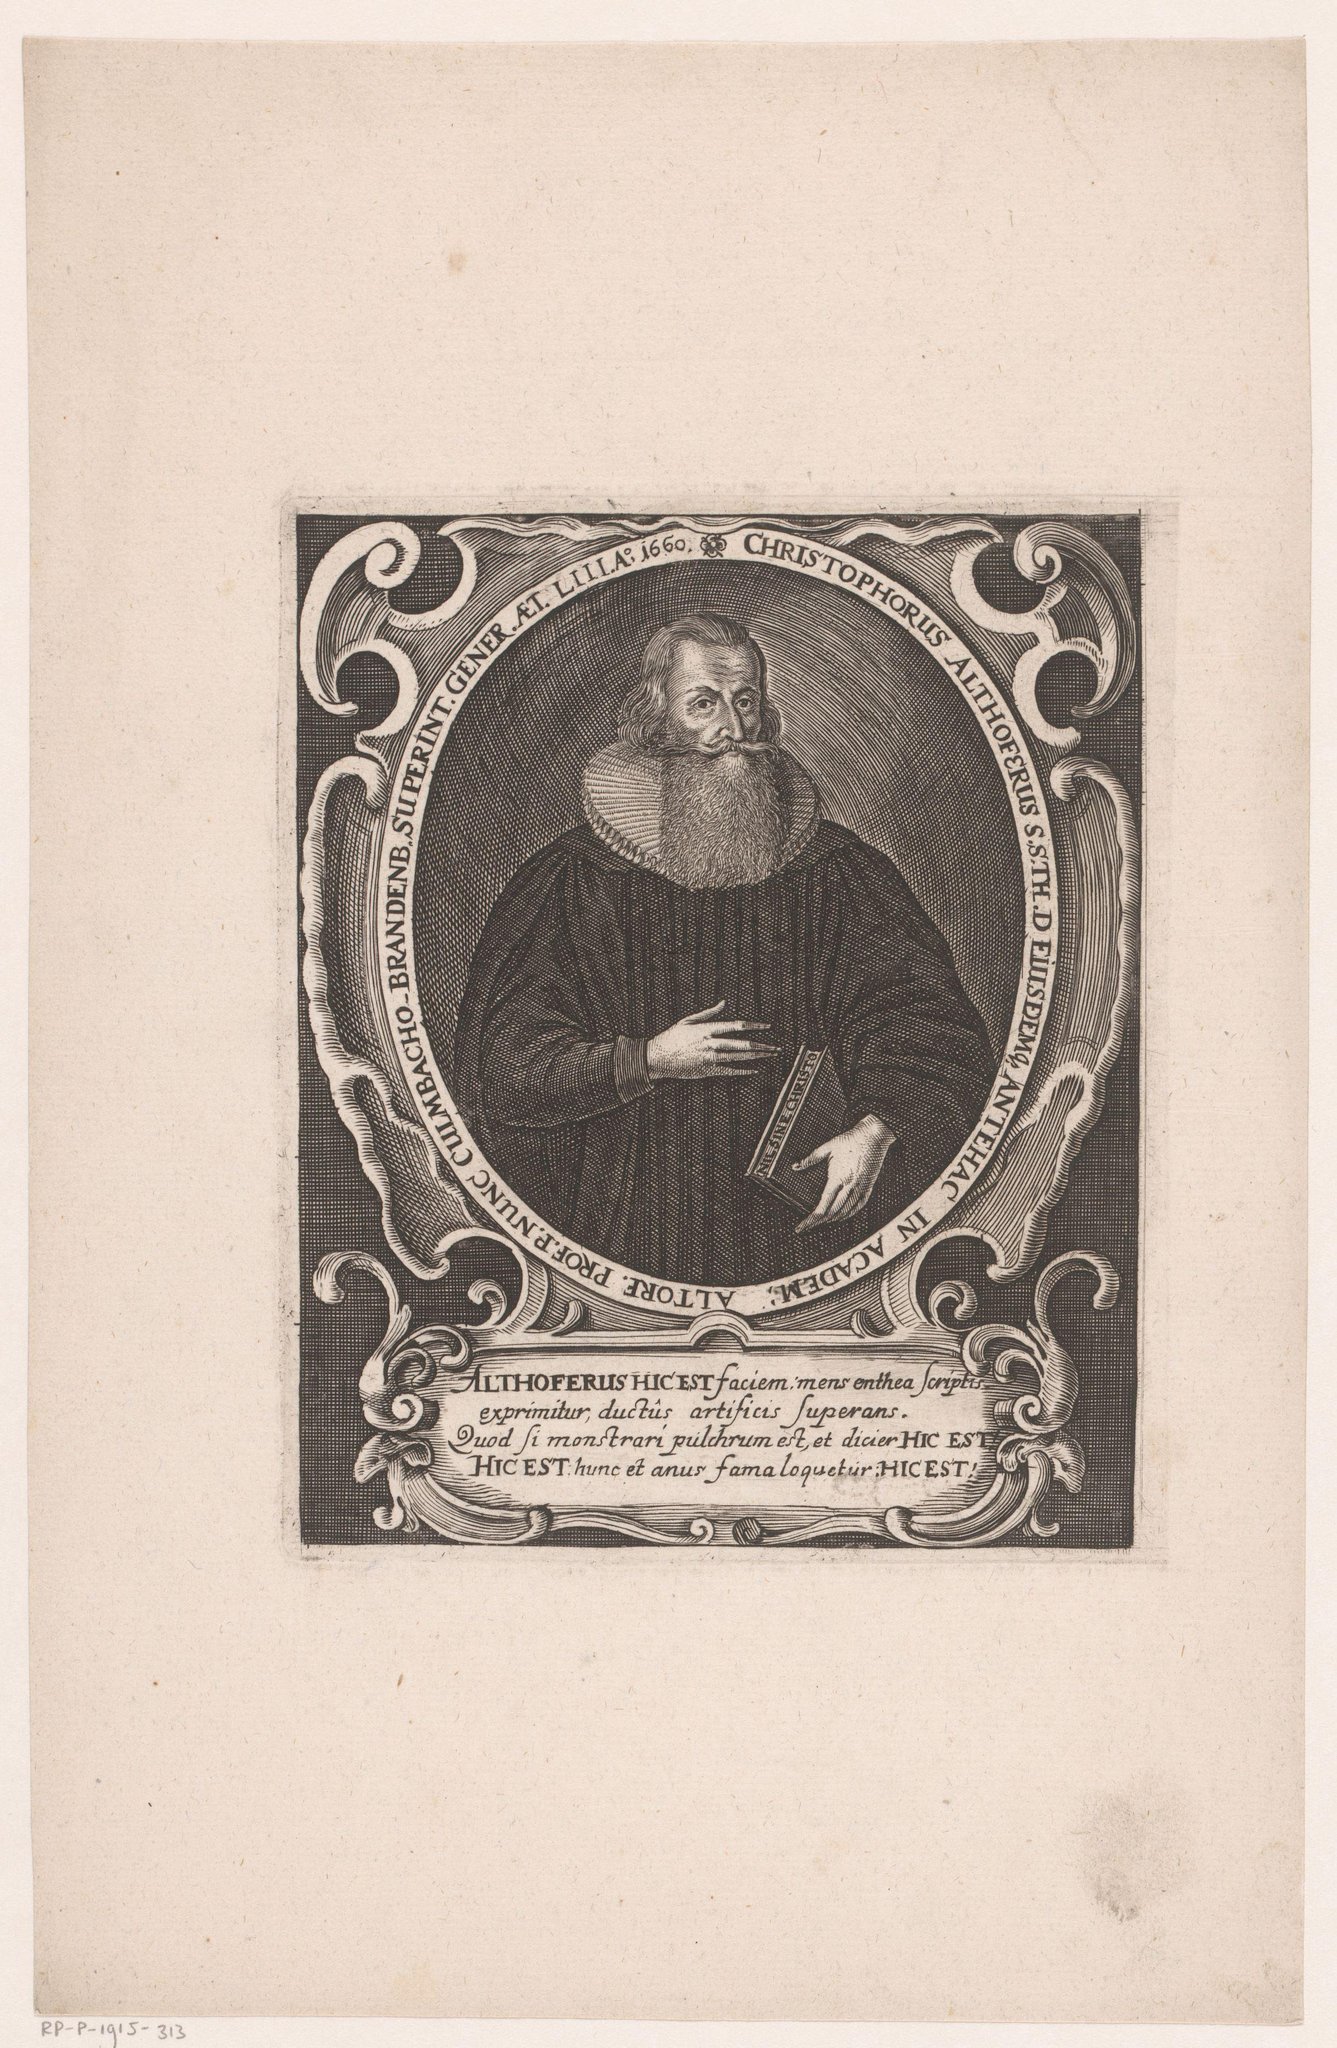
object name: print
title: Portret van Christoph Althofer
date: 1660-1670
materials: paper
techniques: engraving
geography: germany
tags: historical persons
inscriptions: collector's mark: Lugt 2228